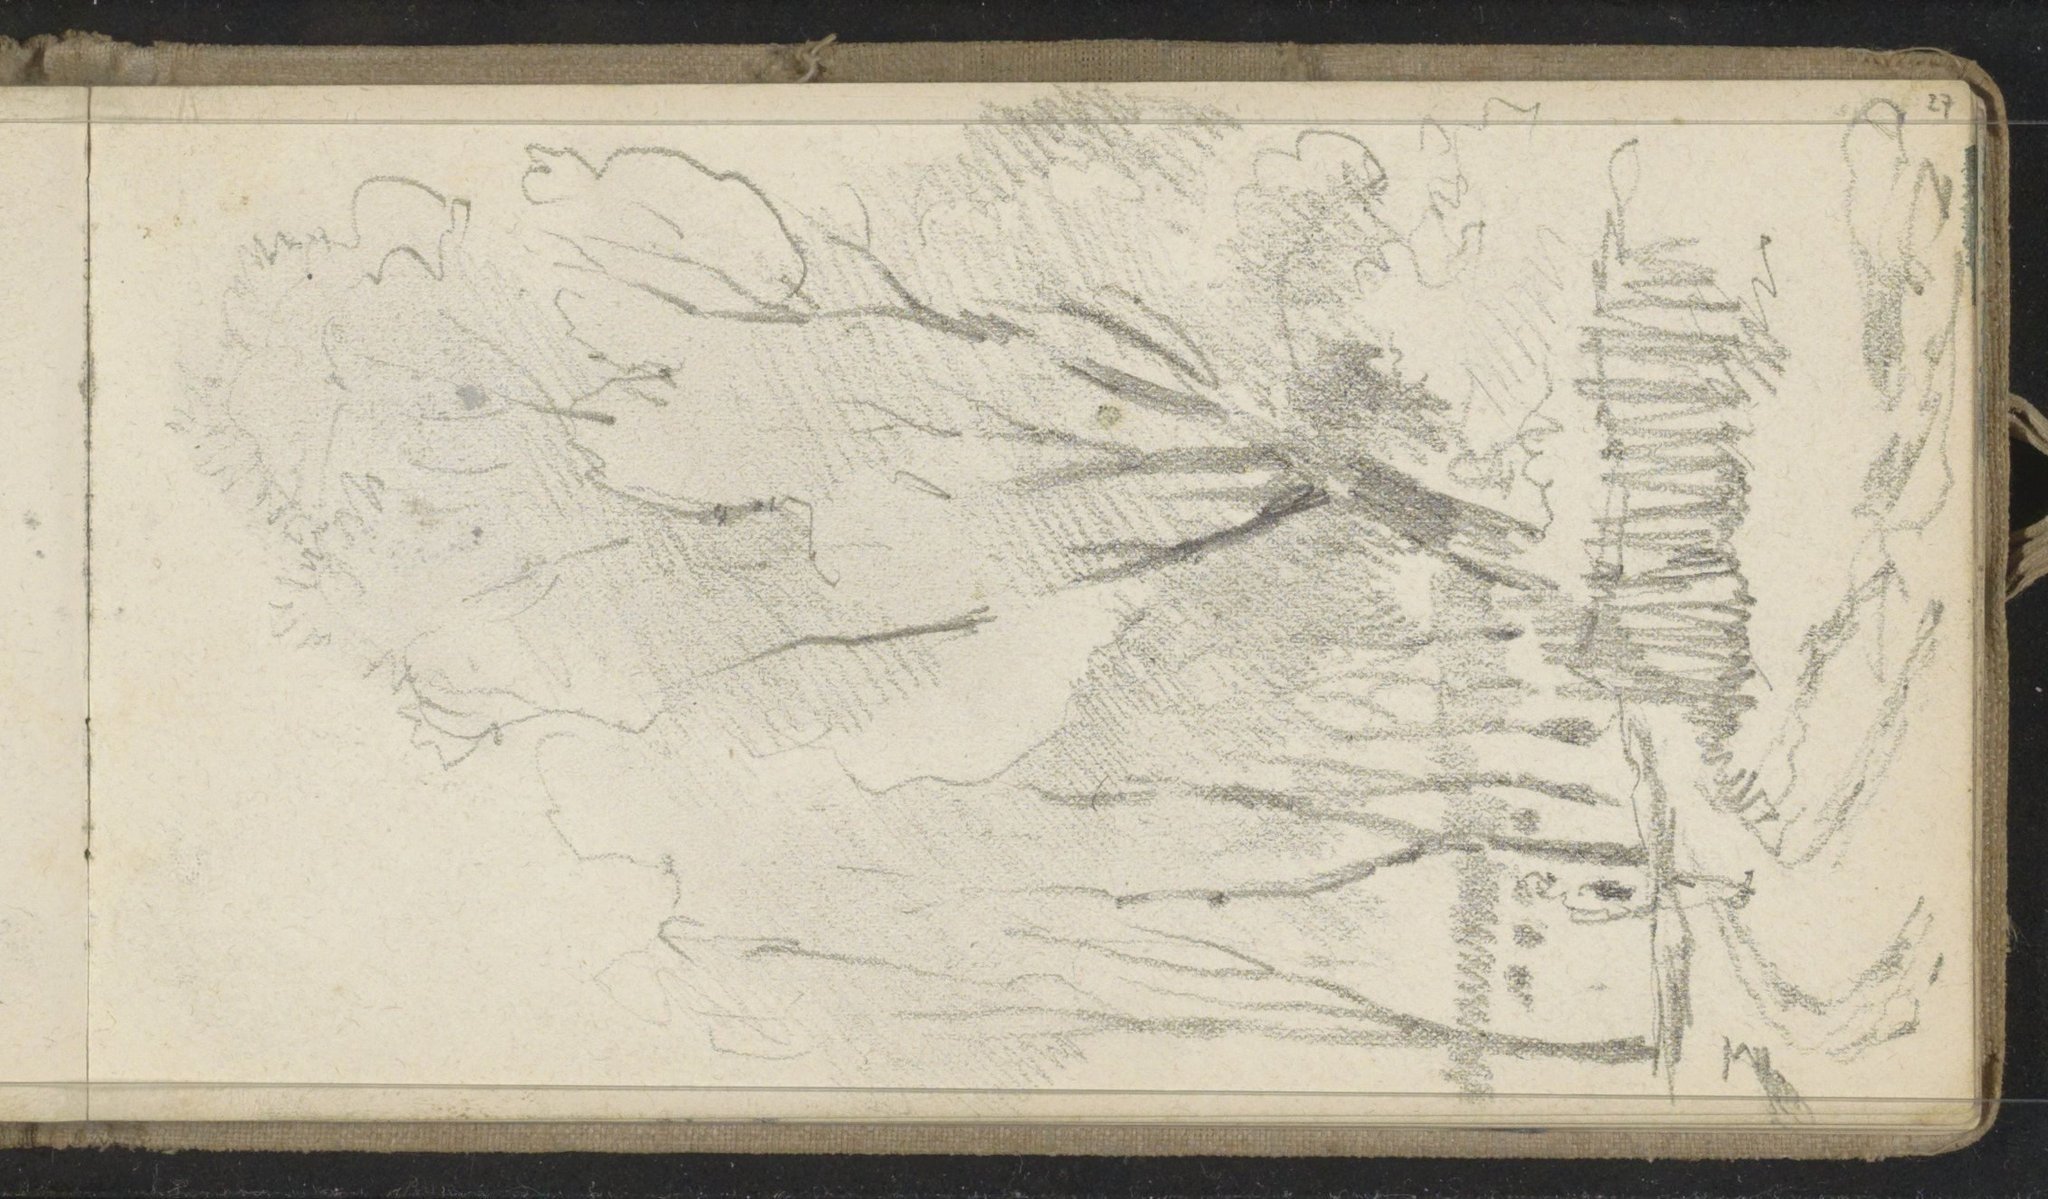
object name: sketchbook leaf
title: Man op een landweg met bomen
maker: willem cornelis rip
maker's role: draughtsman, painter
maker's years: 1856-1922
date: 1895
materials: paper, pencil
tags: road, path, landscapes (+ landscape with figures, staffage)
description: Blad 27 recto uit een schetsboek met 39 bladen.